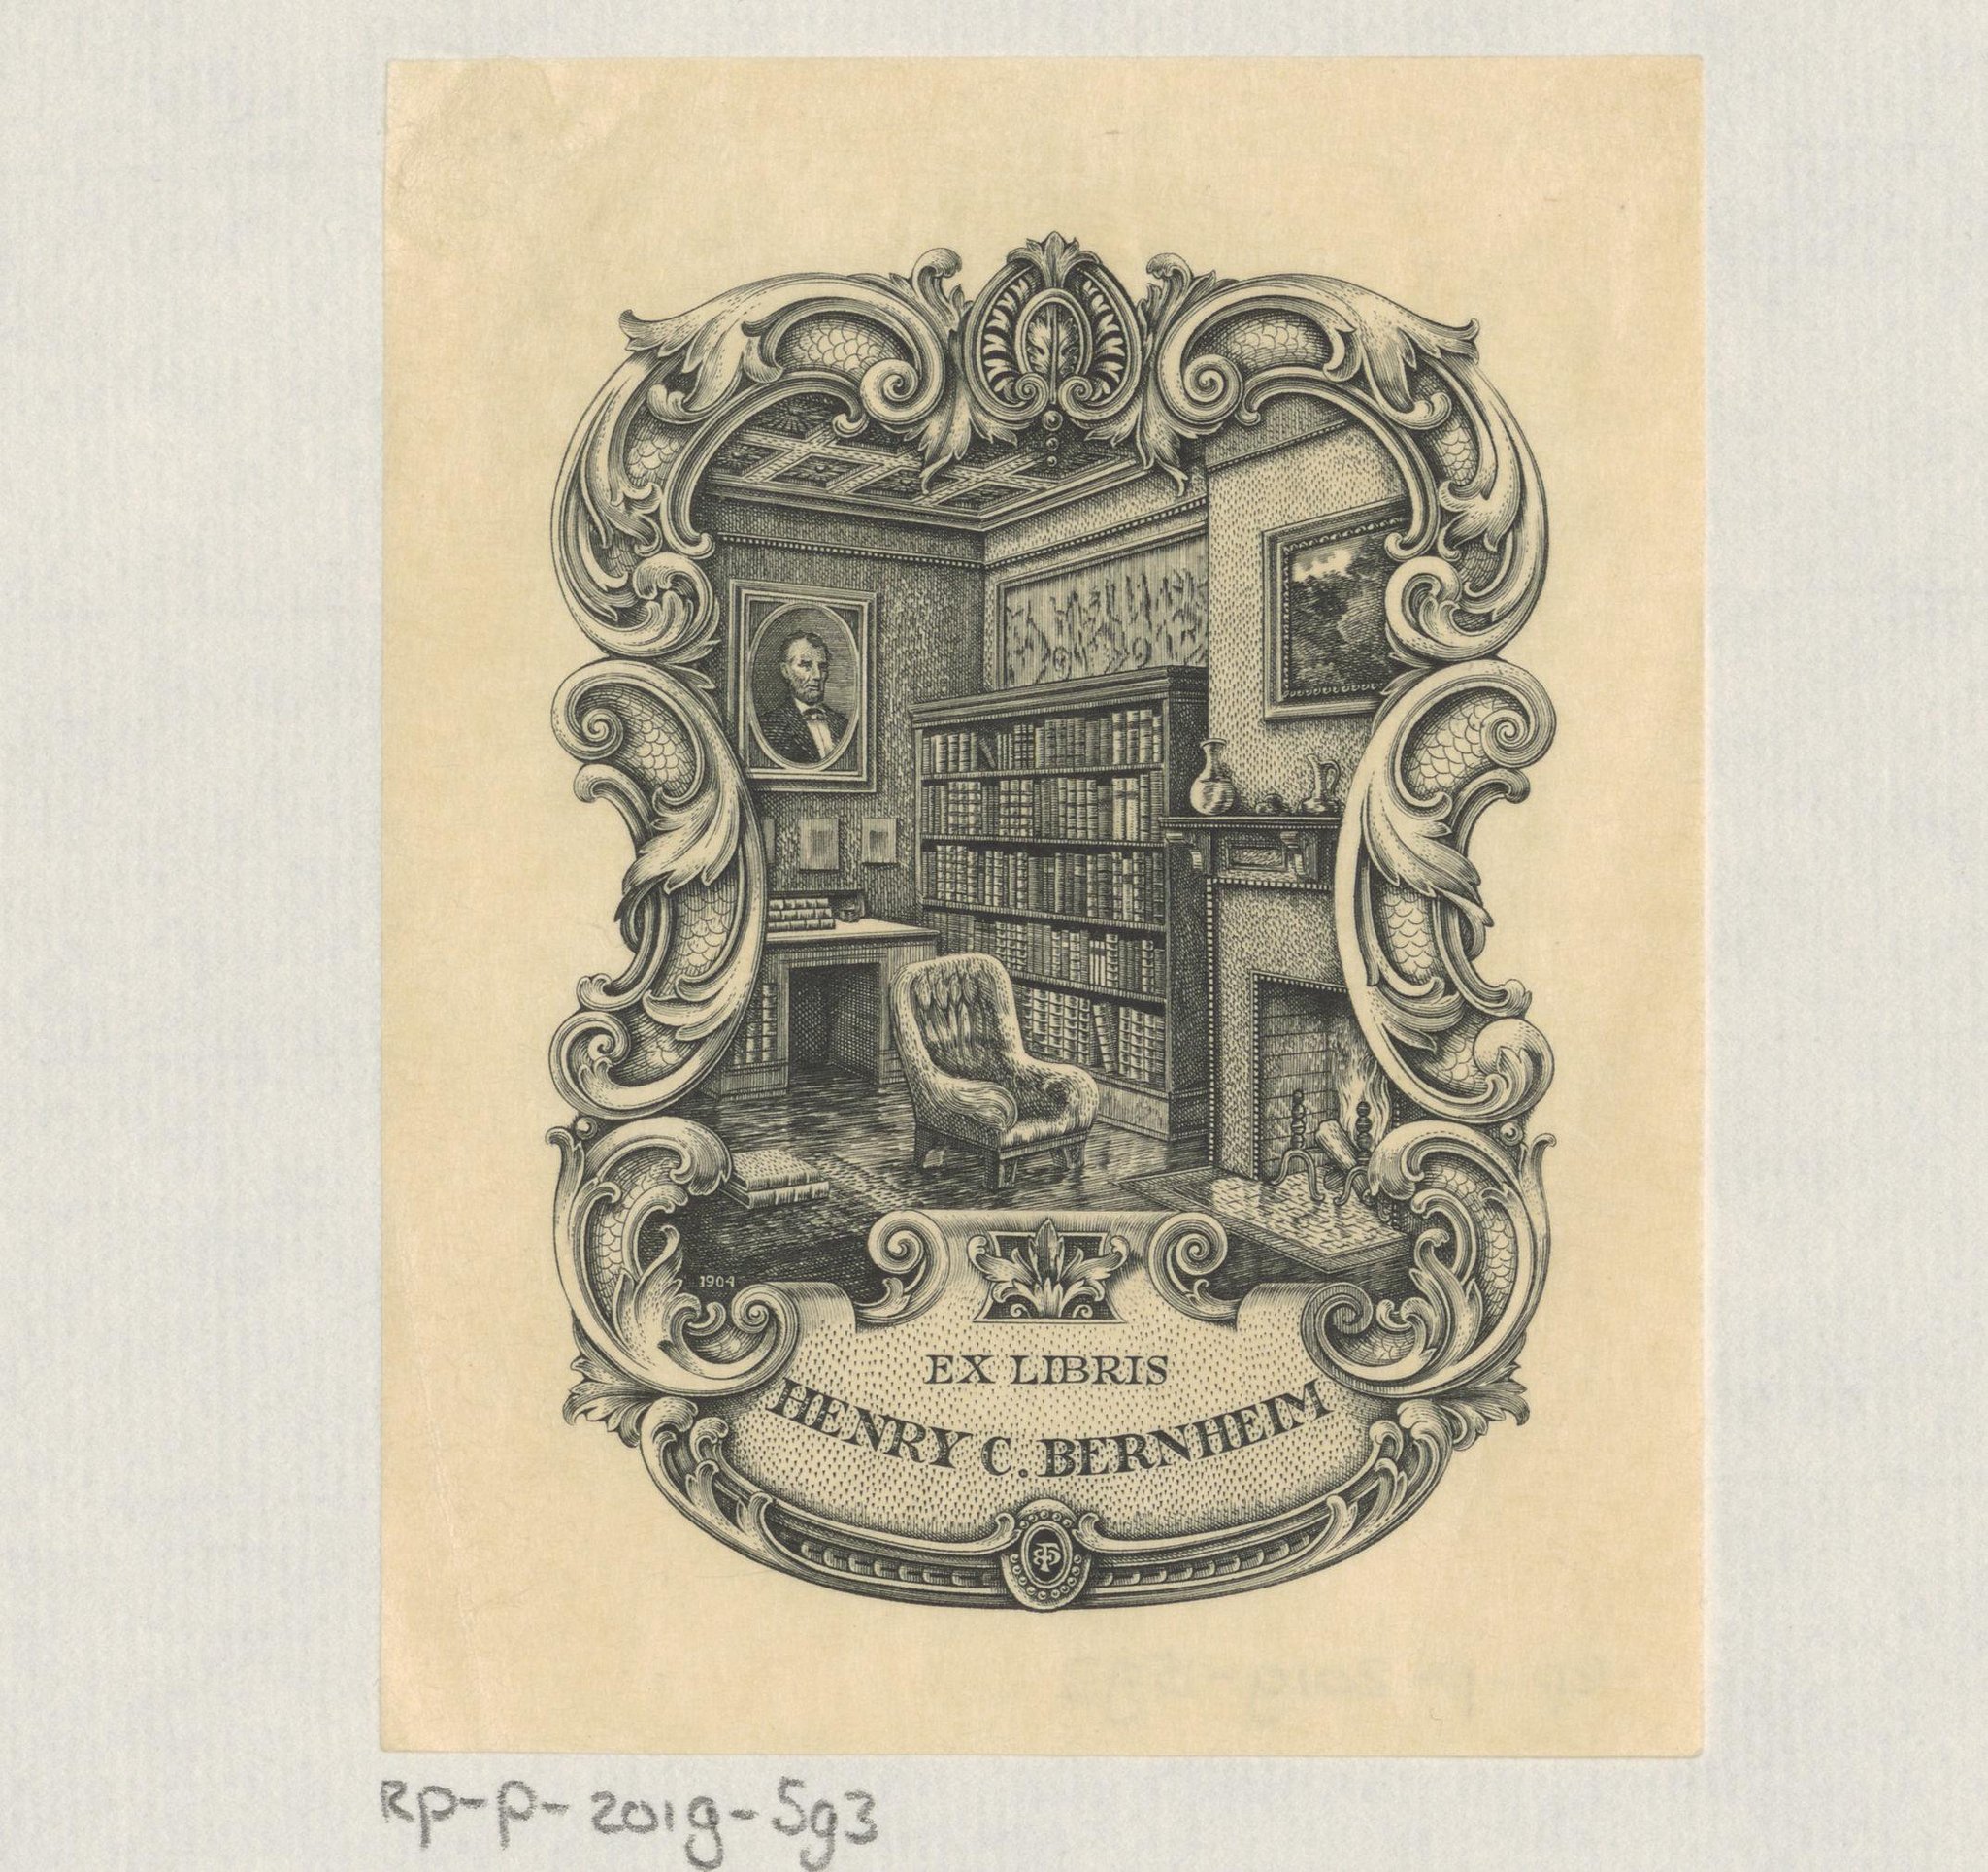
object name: bookplate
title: Ex libris van Henry C. Bernheim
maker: edwin davis french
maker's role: print maker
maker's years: 1851-1906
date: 1904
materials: paper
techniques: engraving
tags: study; 'studiolo'; library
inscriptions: date